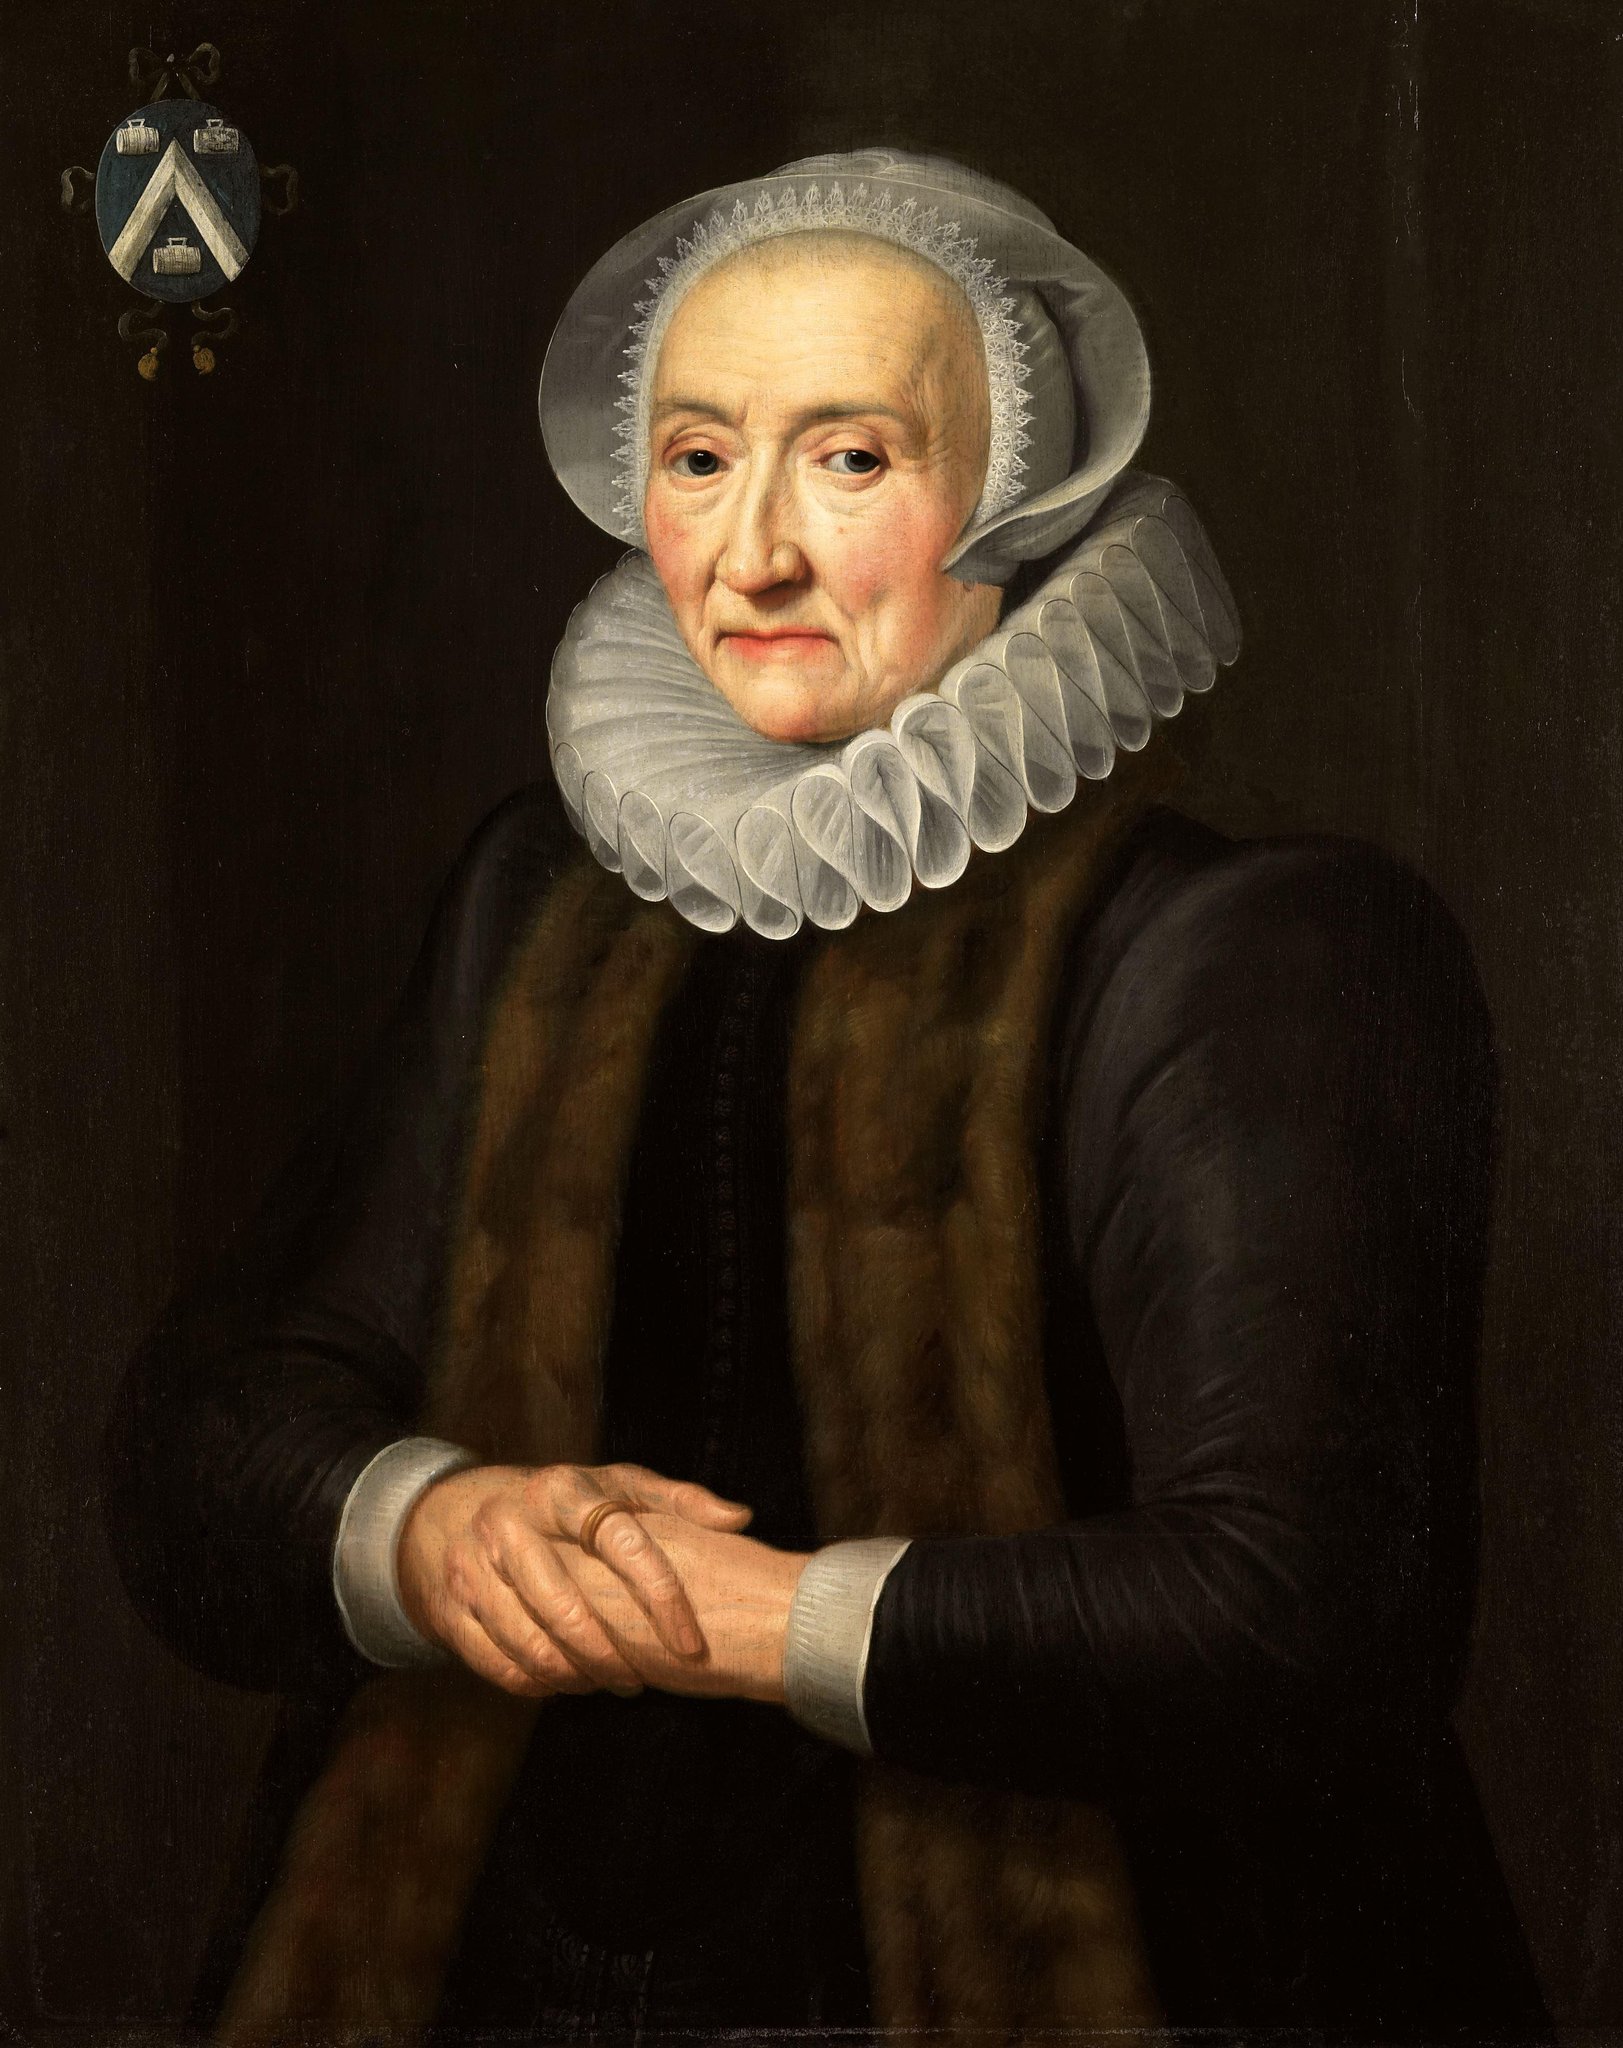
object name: painting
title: Portrait of Alid van der Laen (1542-1626)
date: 1653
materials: oil, panel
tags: mayor, historical persons - bb - woman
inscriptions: coat of arms, top left corner: a silver chevron with three silver, gold-banded barrels on a blue field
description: Portret van Alid van der Laen, echtgenote van Maerten Ruychaver. Ten halven lijve, staande naar links met de handen voor de buik. Pendant van SK-C-520.